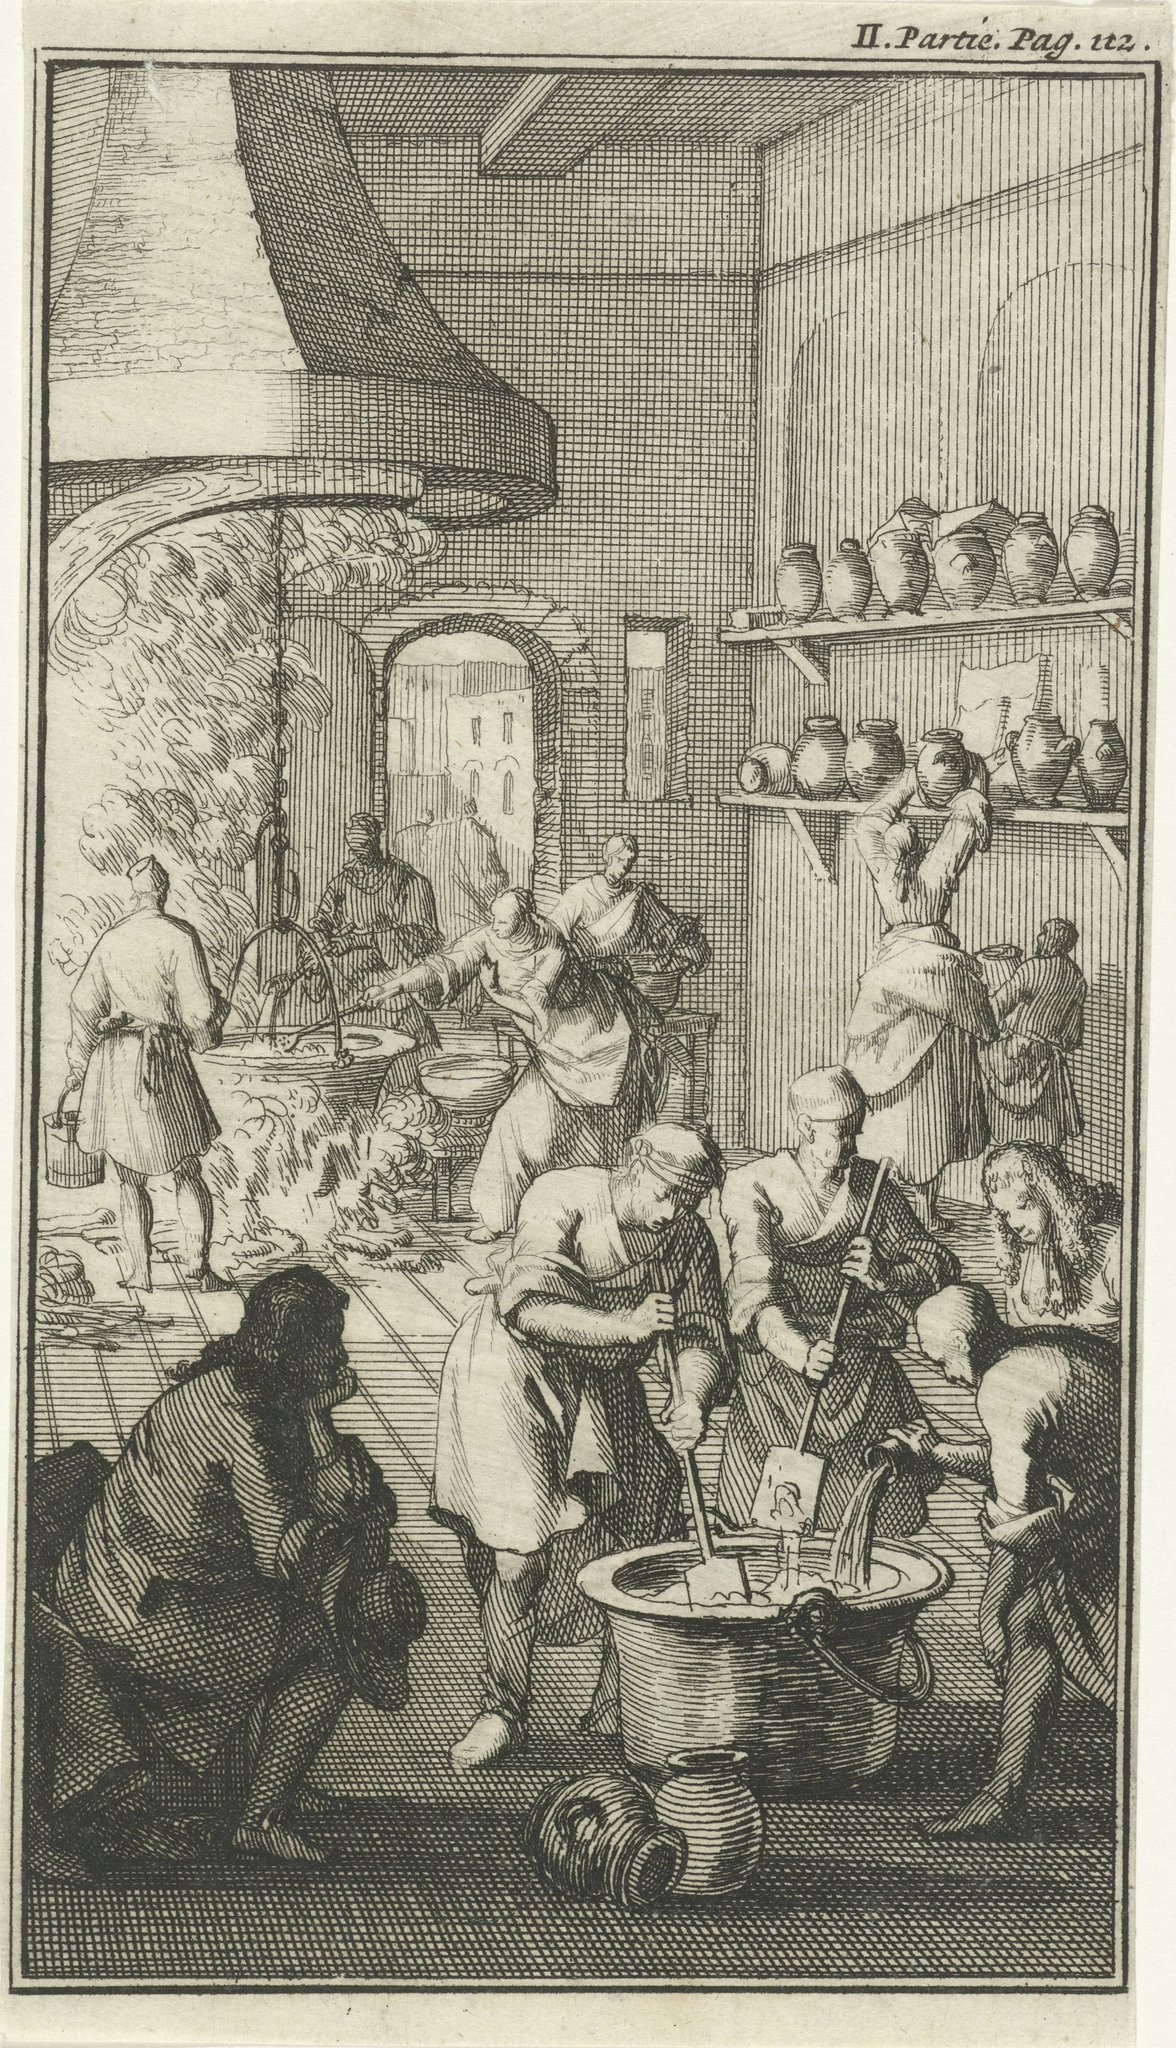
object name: book illustration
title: Vervaardiging van sorbet in een keuken te Rosette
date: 1689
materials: paper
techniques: etching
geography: paris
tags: kitchen-interior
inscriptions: collector's mark: Lugt 2228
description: Illustratie uit: Thevenot, Jean de. Voyages Tant en Europe qu'en Asie et en Afrique, 4 delen. Parijs: Charles Angot, 1689, dl. III.